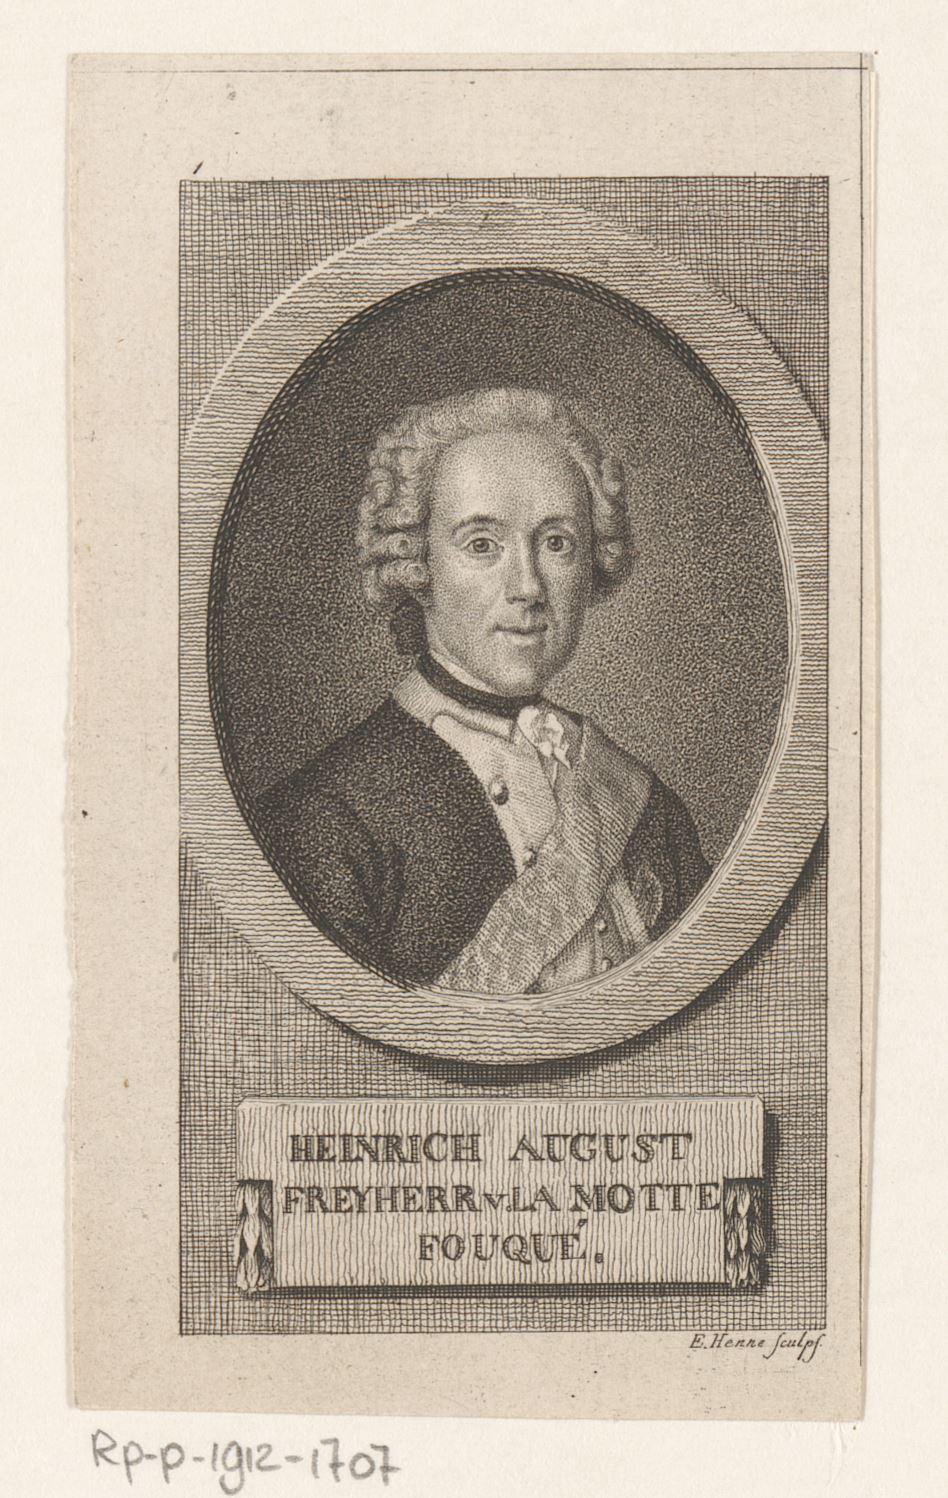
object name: print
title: Portret van Heinrich August de la Motte Fouqué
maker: eberhard siegfried henne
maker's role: print maker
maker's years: 1759-1828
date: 1769-1828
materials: paper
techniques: engraving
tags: the hague, commander-in-chief, general, marshal, historical persons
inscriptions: collector's mark: Lugt 2228